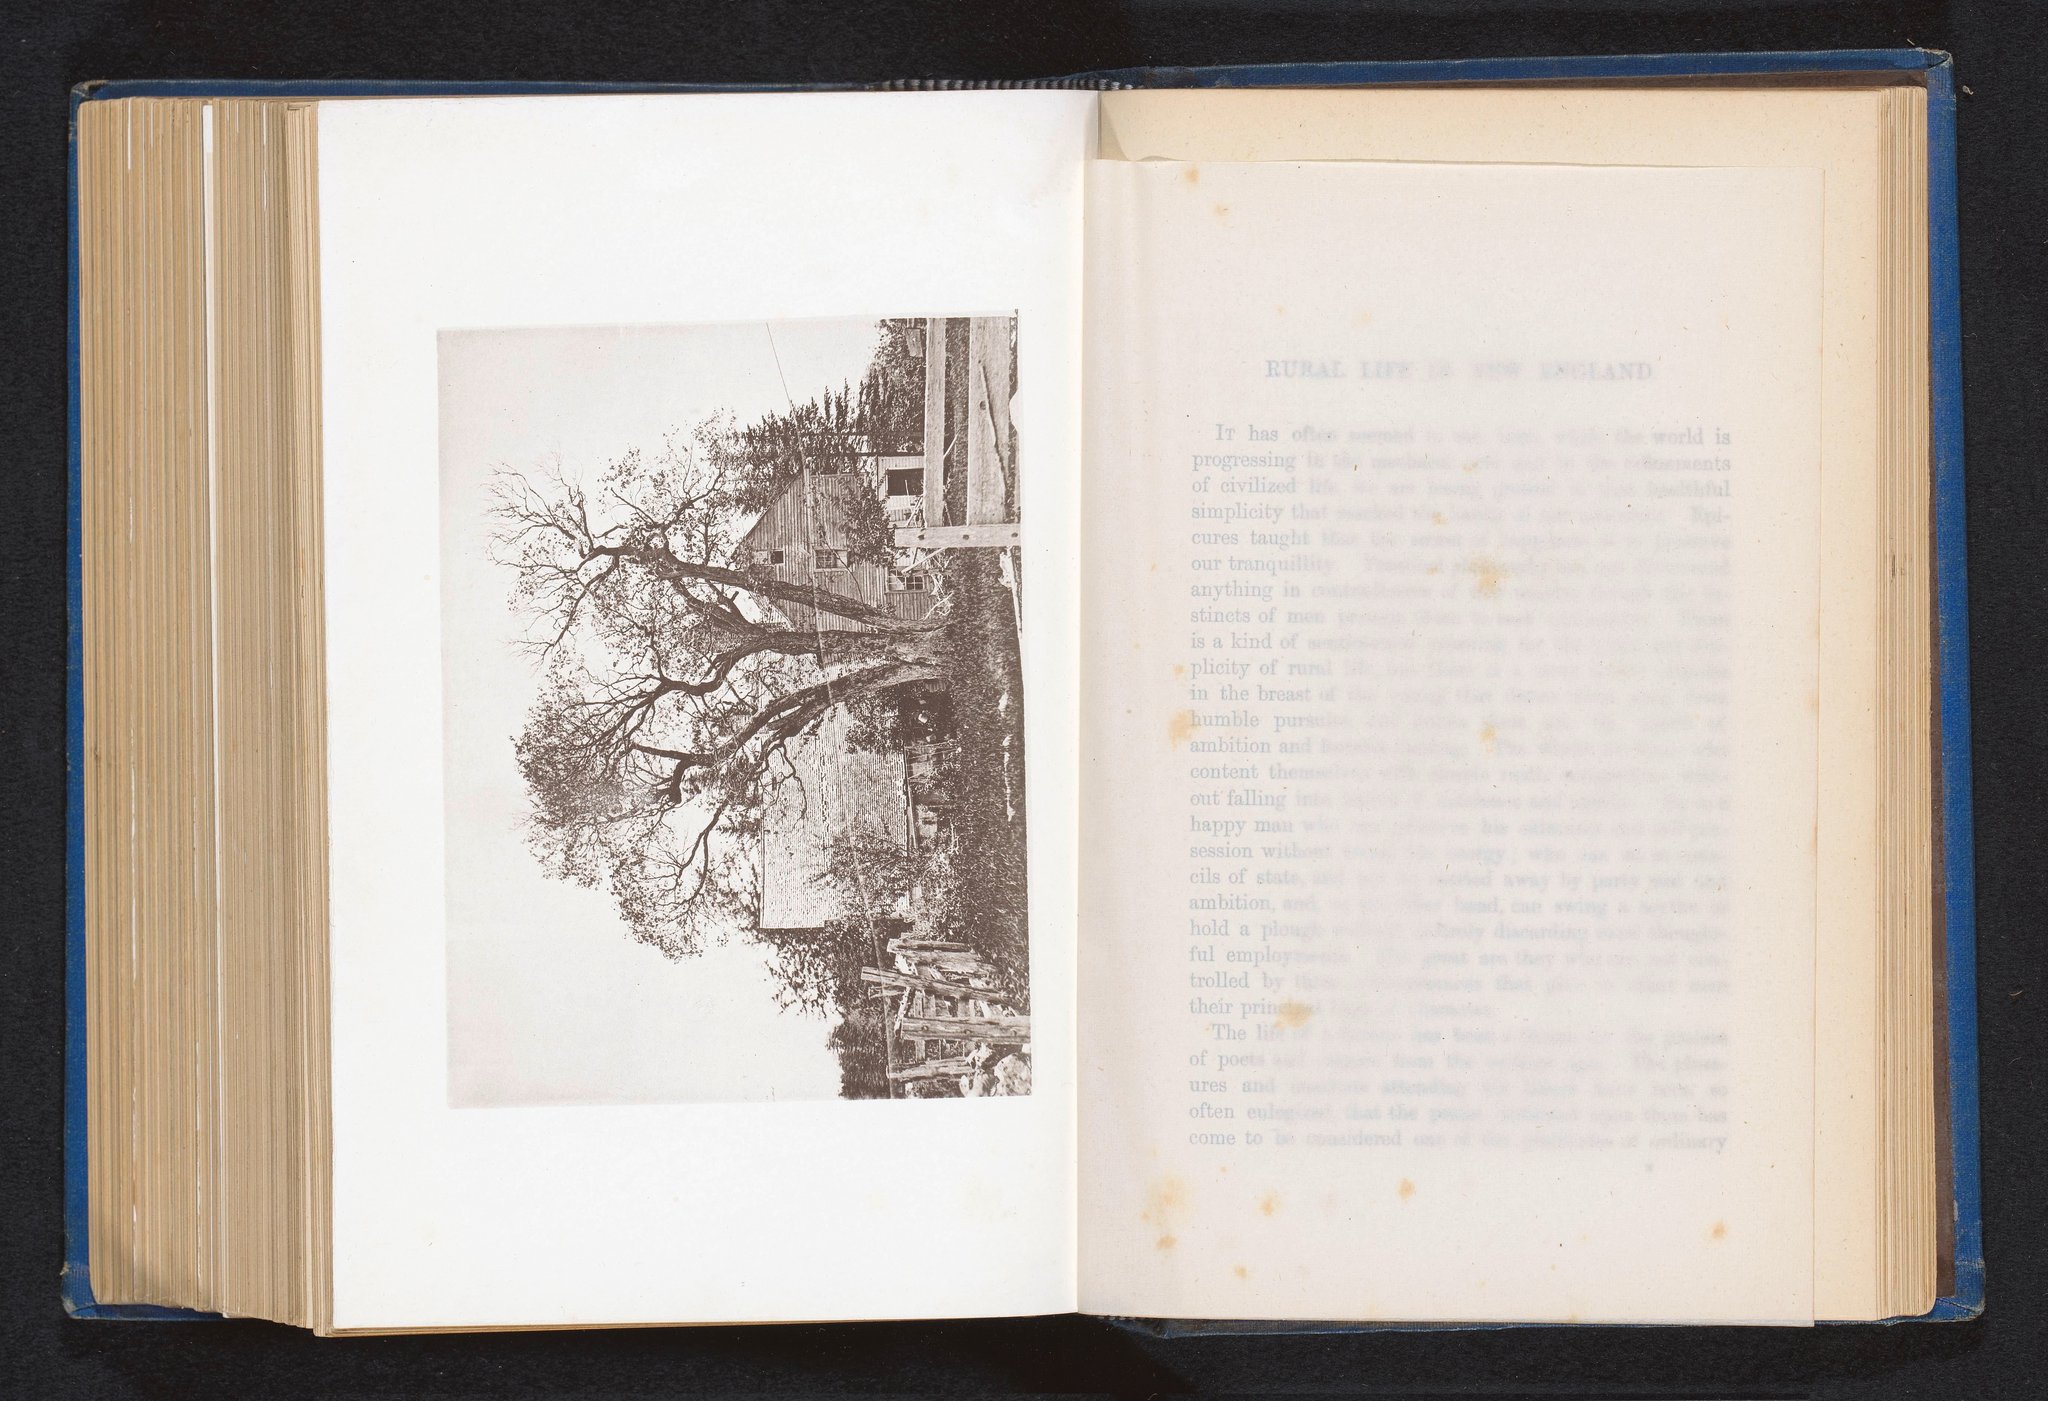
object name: photomechanical print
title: Gezicht op een moerbeiboom te Wyoming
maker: Anonymous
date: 1872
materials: paper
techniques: photograph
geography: wyoming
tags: landscapes, trees: mulberry-tree, façade (of house or building)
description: Prent op tweede ongenummerde pagina na pagina 400.